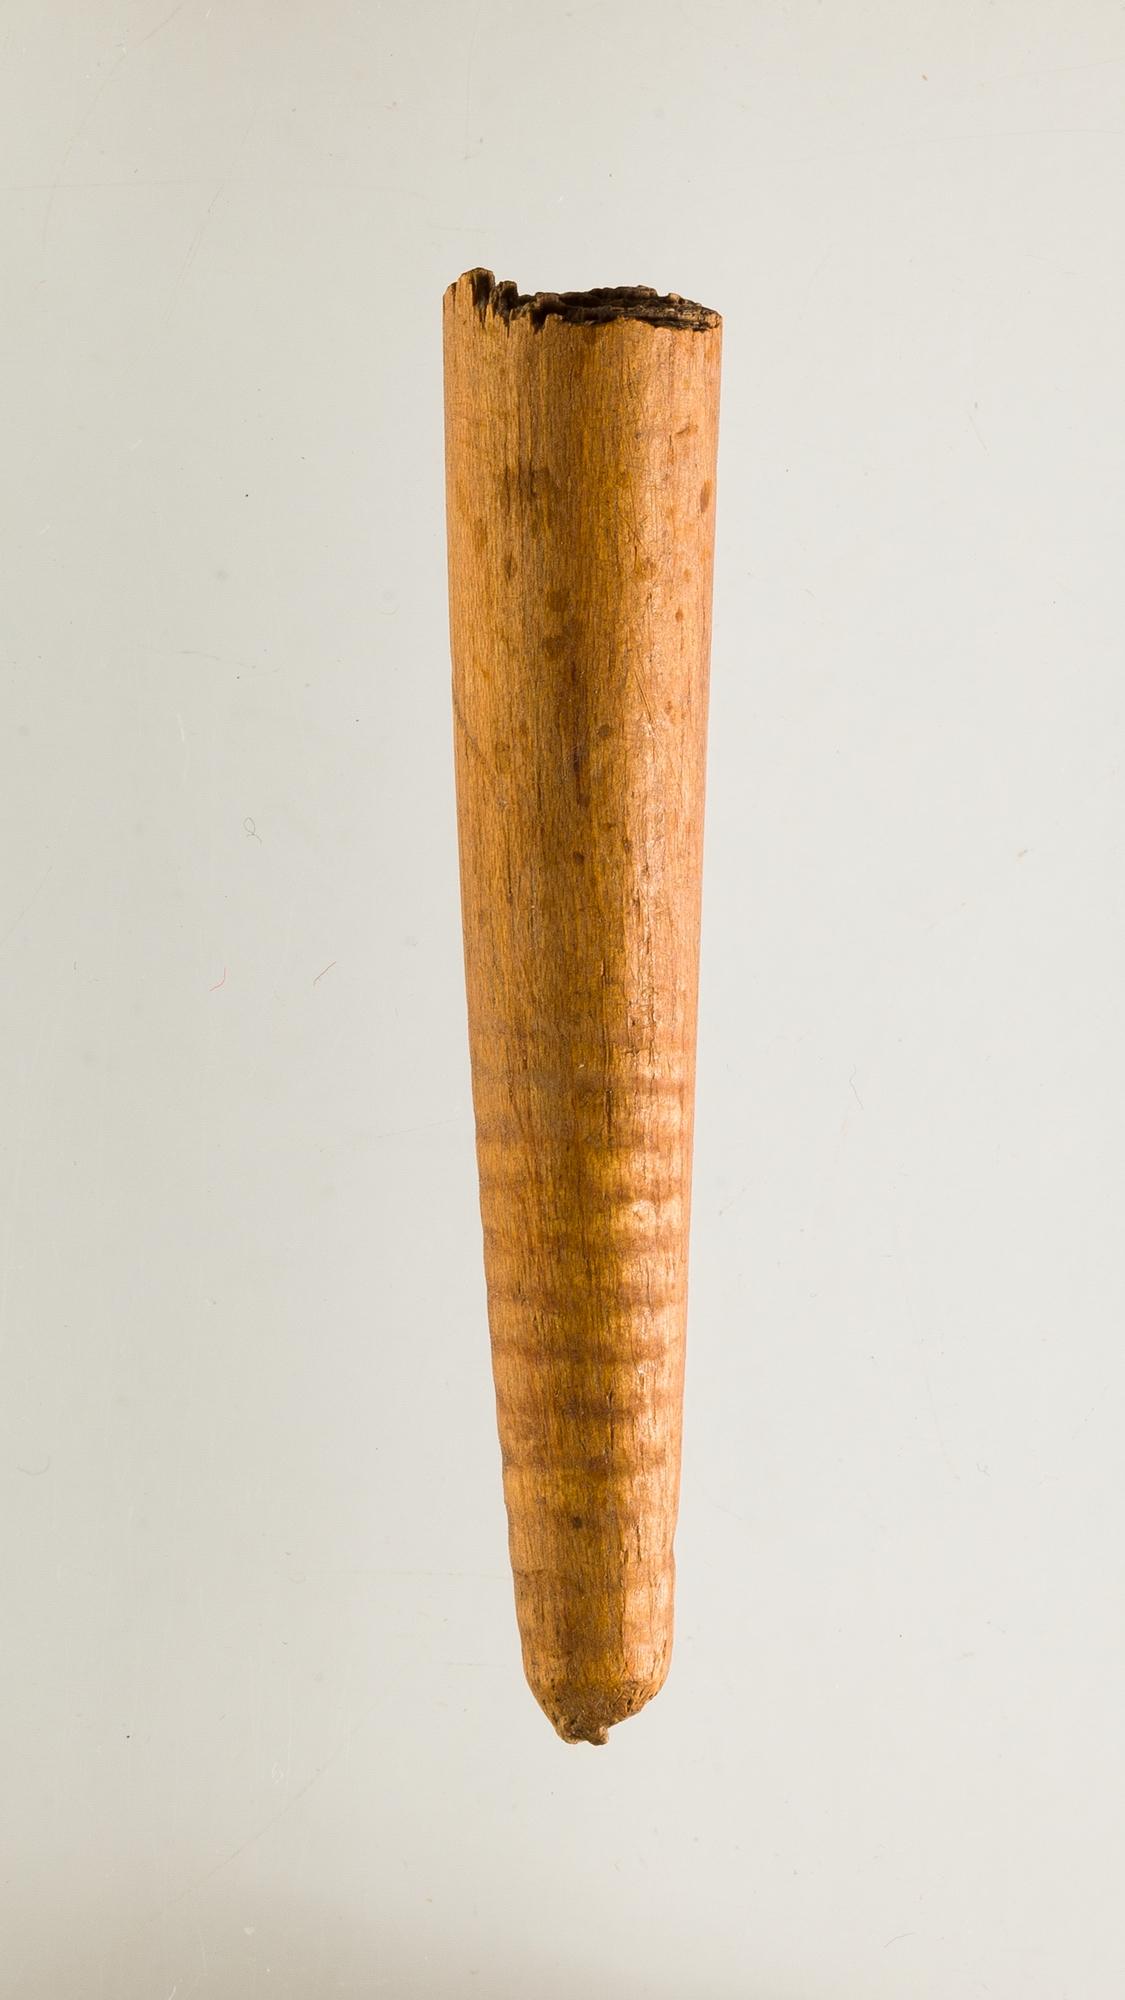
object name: bow tip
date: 2120-1981 BCE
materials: wood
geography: egypt